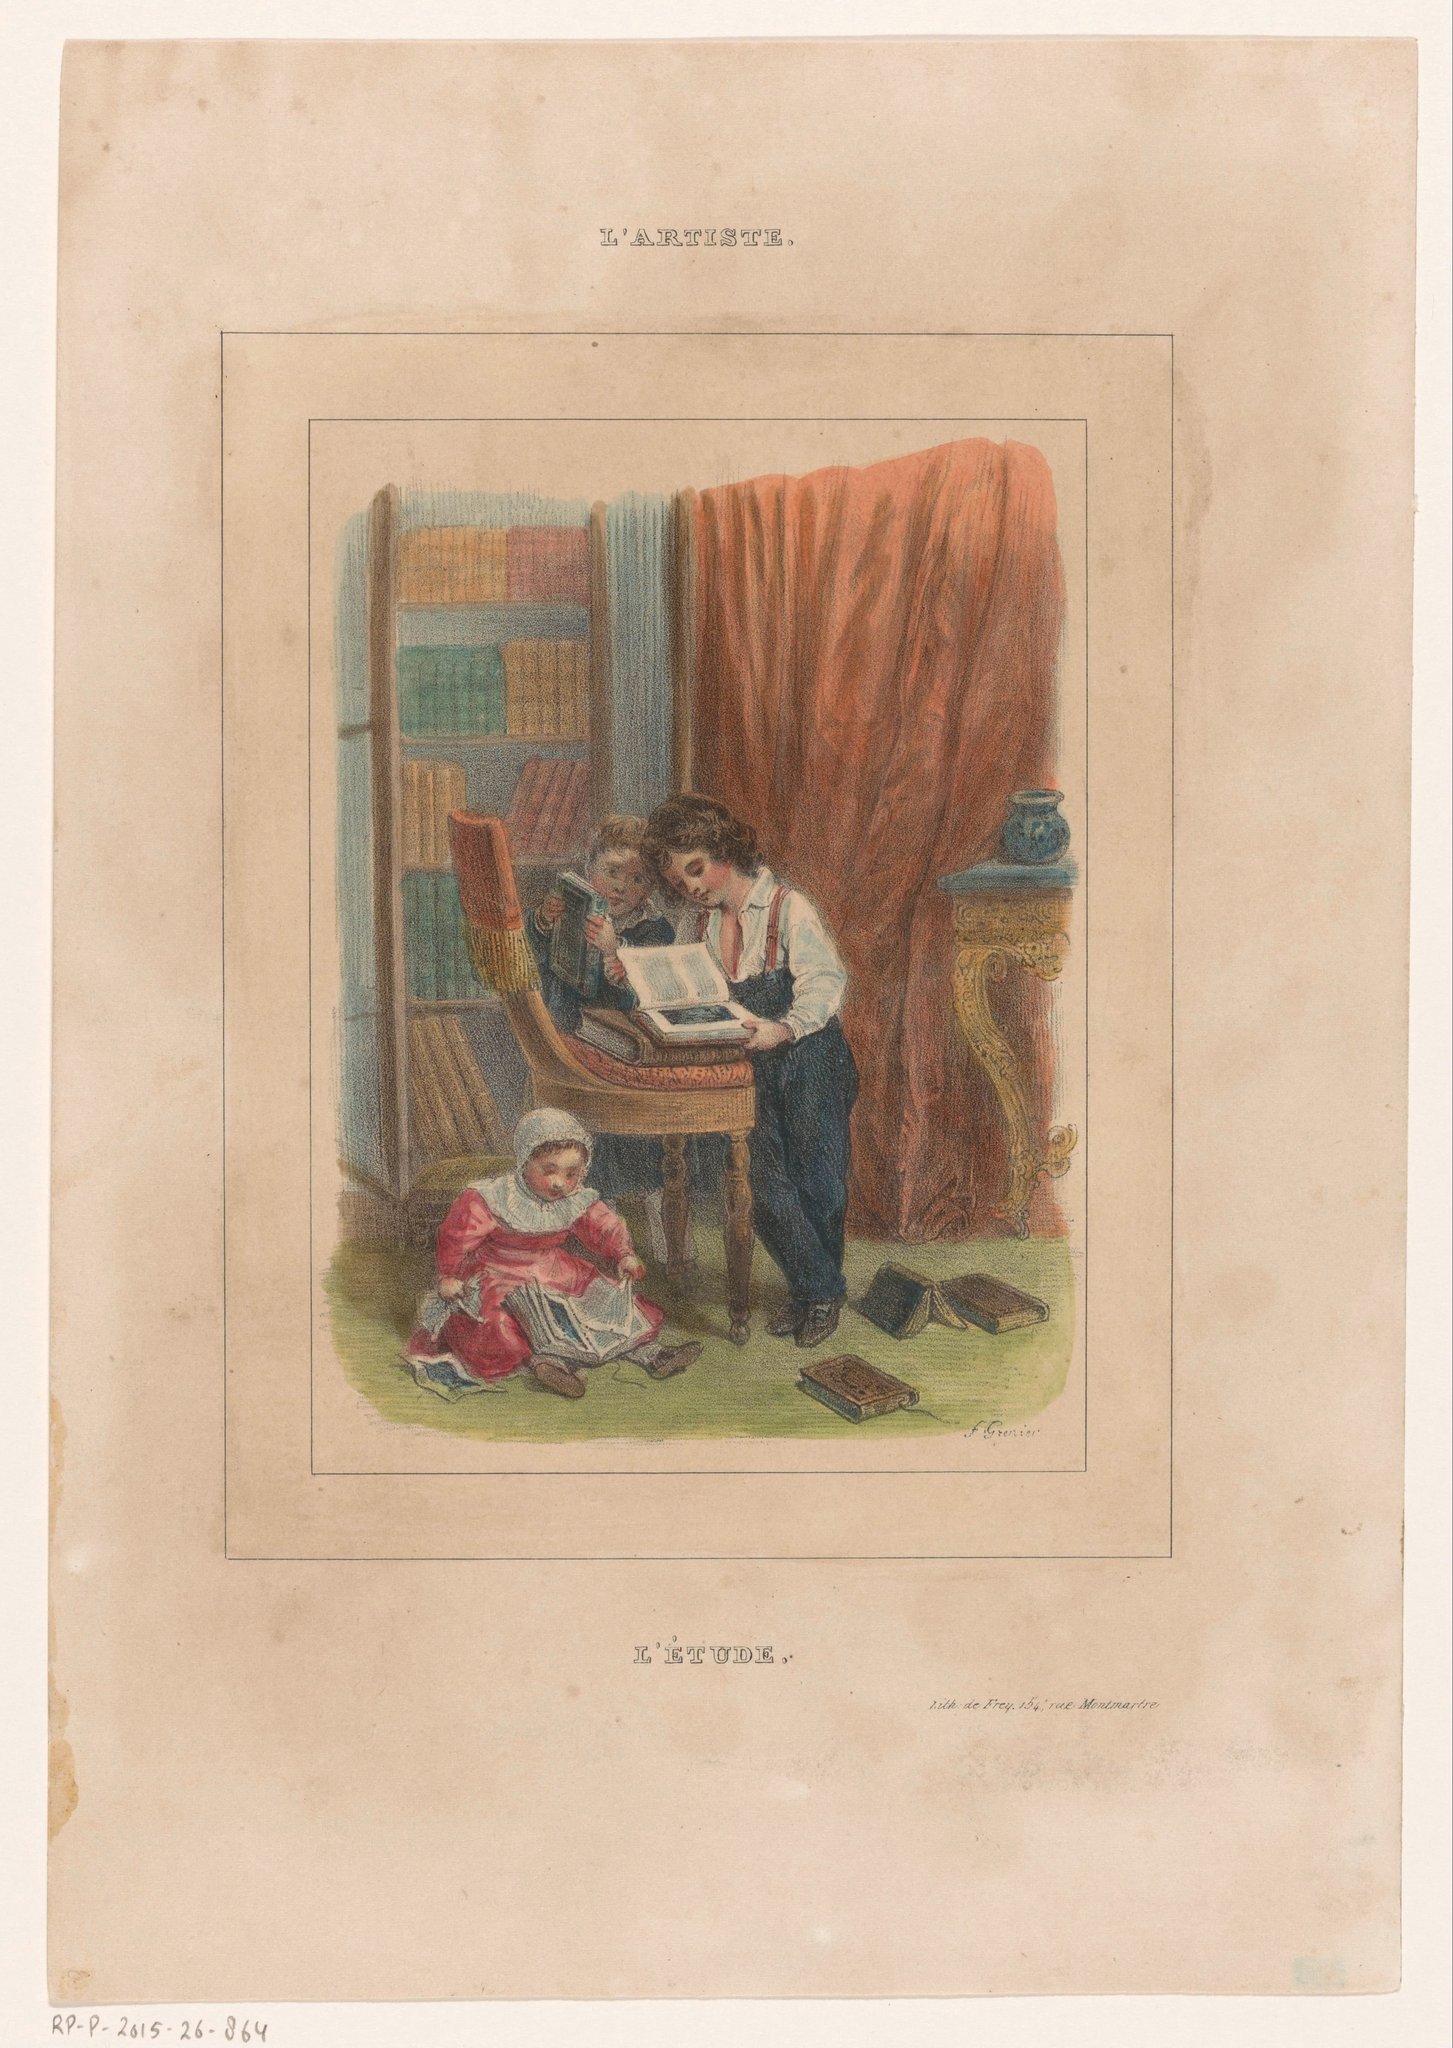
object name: print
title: Drie kinderen bekijken boeken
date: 1831-1867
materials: paper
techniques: hand coloring, lithograph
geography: paris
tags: toddler - aa - girl, book in which illustrations are essential - mm - book open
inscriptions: collector's mark: Lugt 4779, collector's mark: Lugt 4780, collector's mark: Lugt 2228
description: Twee jongens bekijken een boek met afbeeldingen dat zij op een stoel hebben neergelegd, achter hen een geopende boekenkast. Op de grond een peuter die bladzijden uit een boek scheurt.